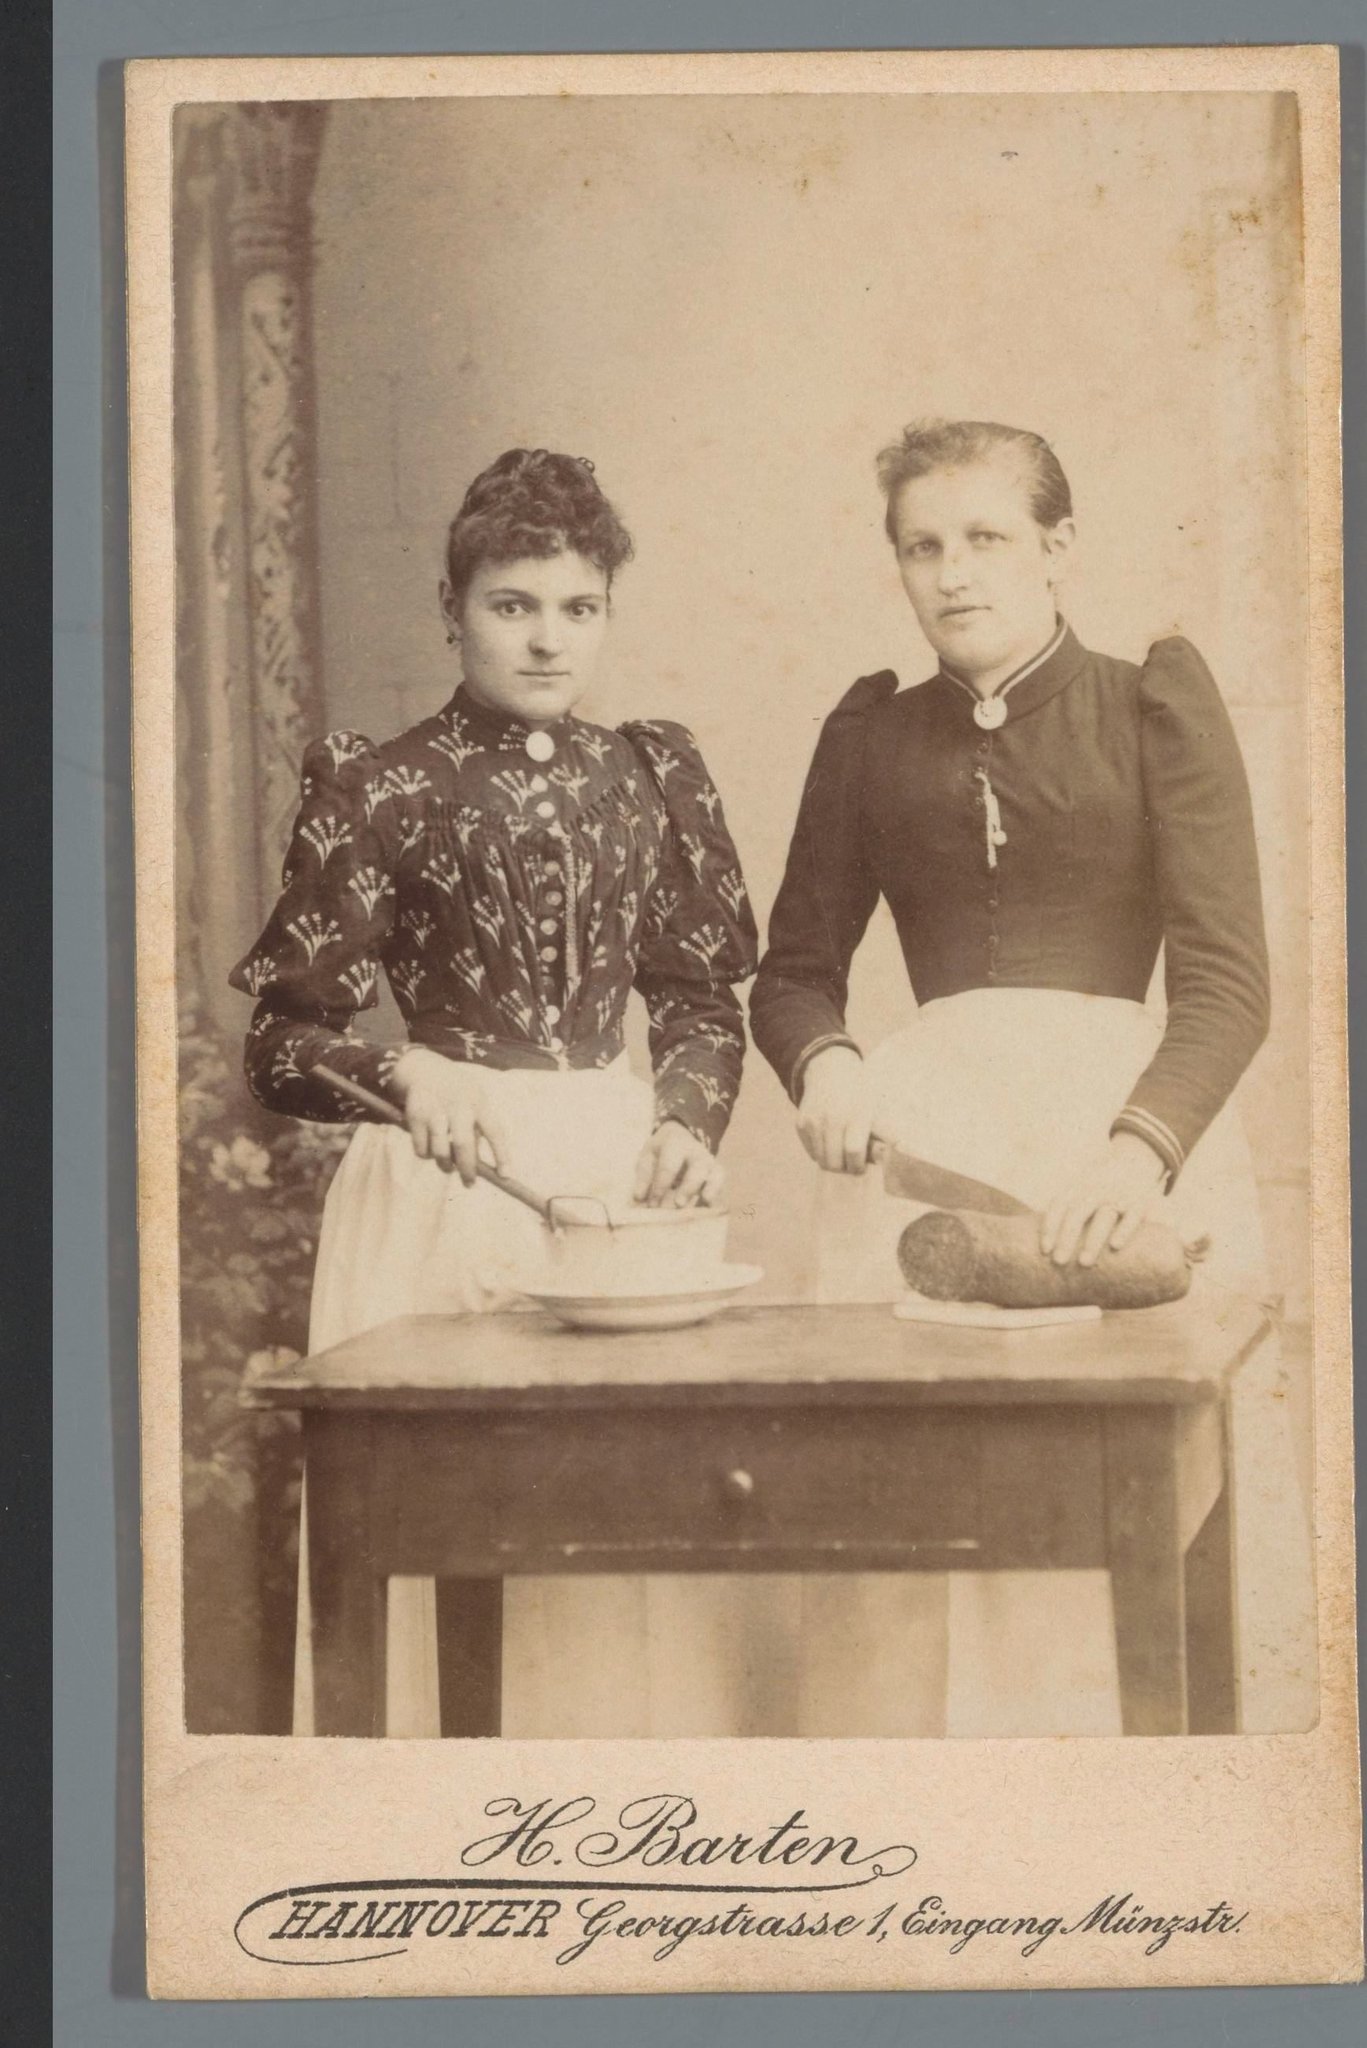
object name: photograph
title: Portret van twee onbekende vrouwen met keukengerei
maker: h. barten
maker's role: fotograaf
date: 1855-1885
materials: cardboard, paper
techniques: albumen print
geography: hannover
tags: adult woman, anonymous historical person portrayed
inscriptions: inscription: ‘Die Platte bleibt für Nachbestellungen aufbewahrt./ Vergrösserungen nach jedem Bilde./ PRAGER & LOJDA, BERLIN’, address: ‘HANNOVER/ Georg-Strasse 1/ Eingang Münzstr.’